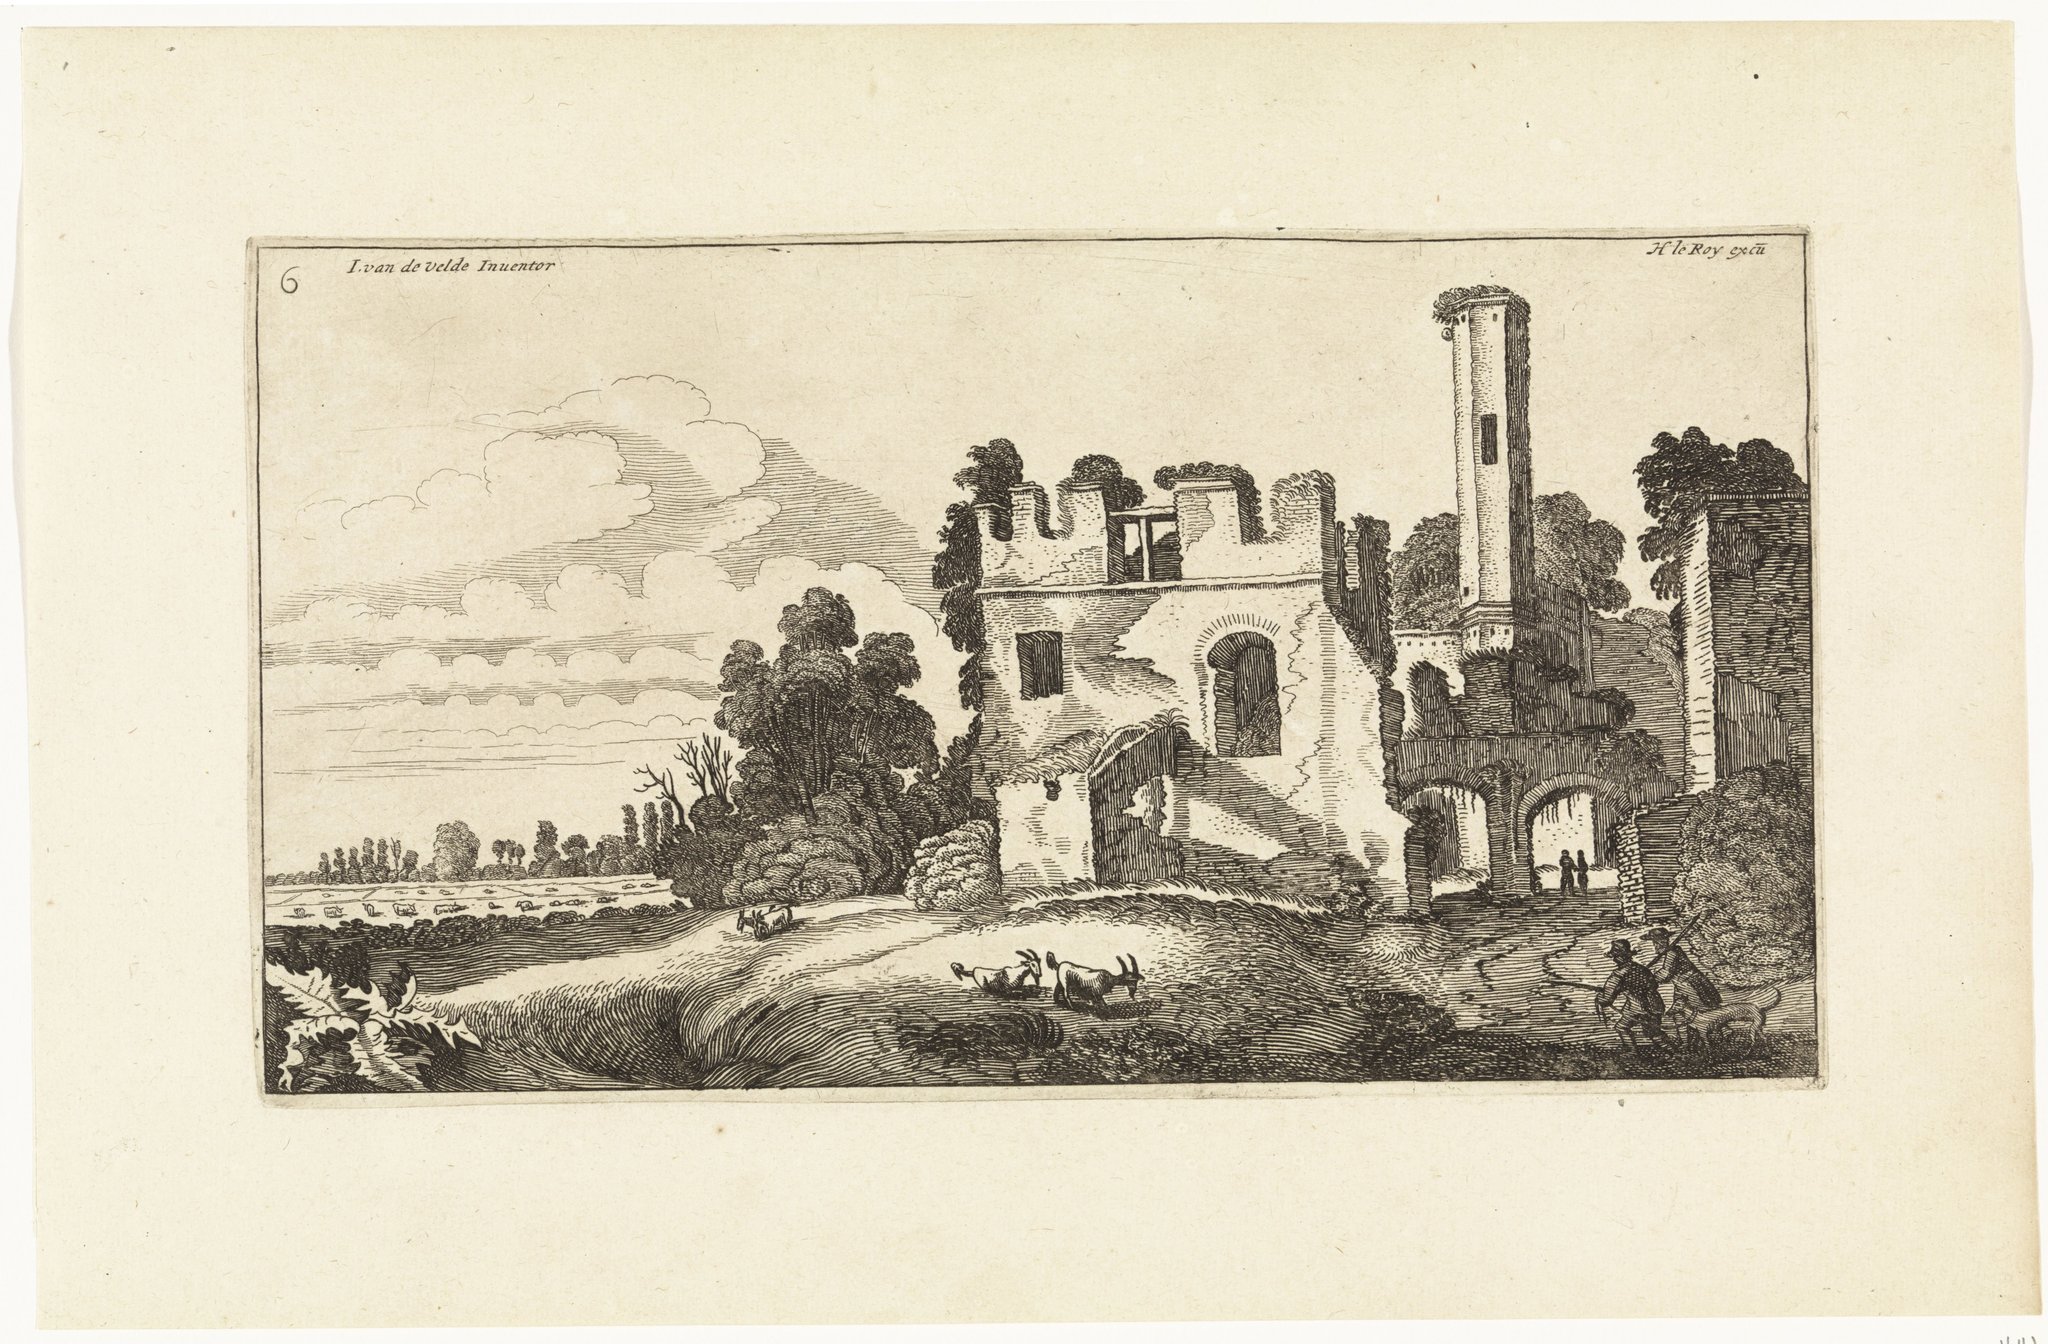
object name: print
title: Landschap met ruïne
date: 1602-1649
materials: paper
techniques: etching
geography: amsterdam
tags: ruin of a dwelling, house, castle, etc.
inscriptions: collector's mark: Lugt 2228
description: Twee mannen met een windhond lopen in de richting van een kasteelruïne.